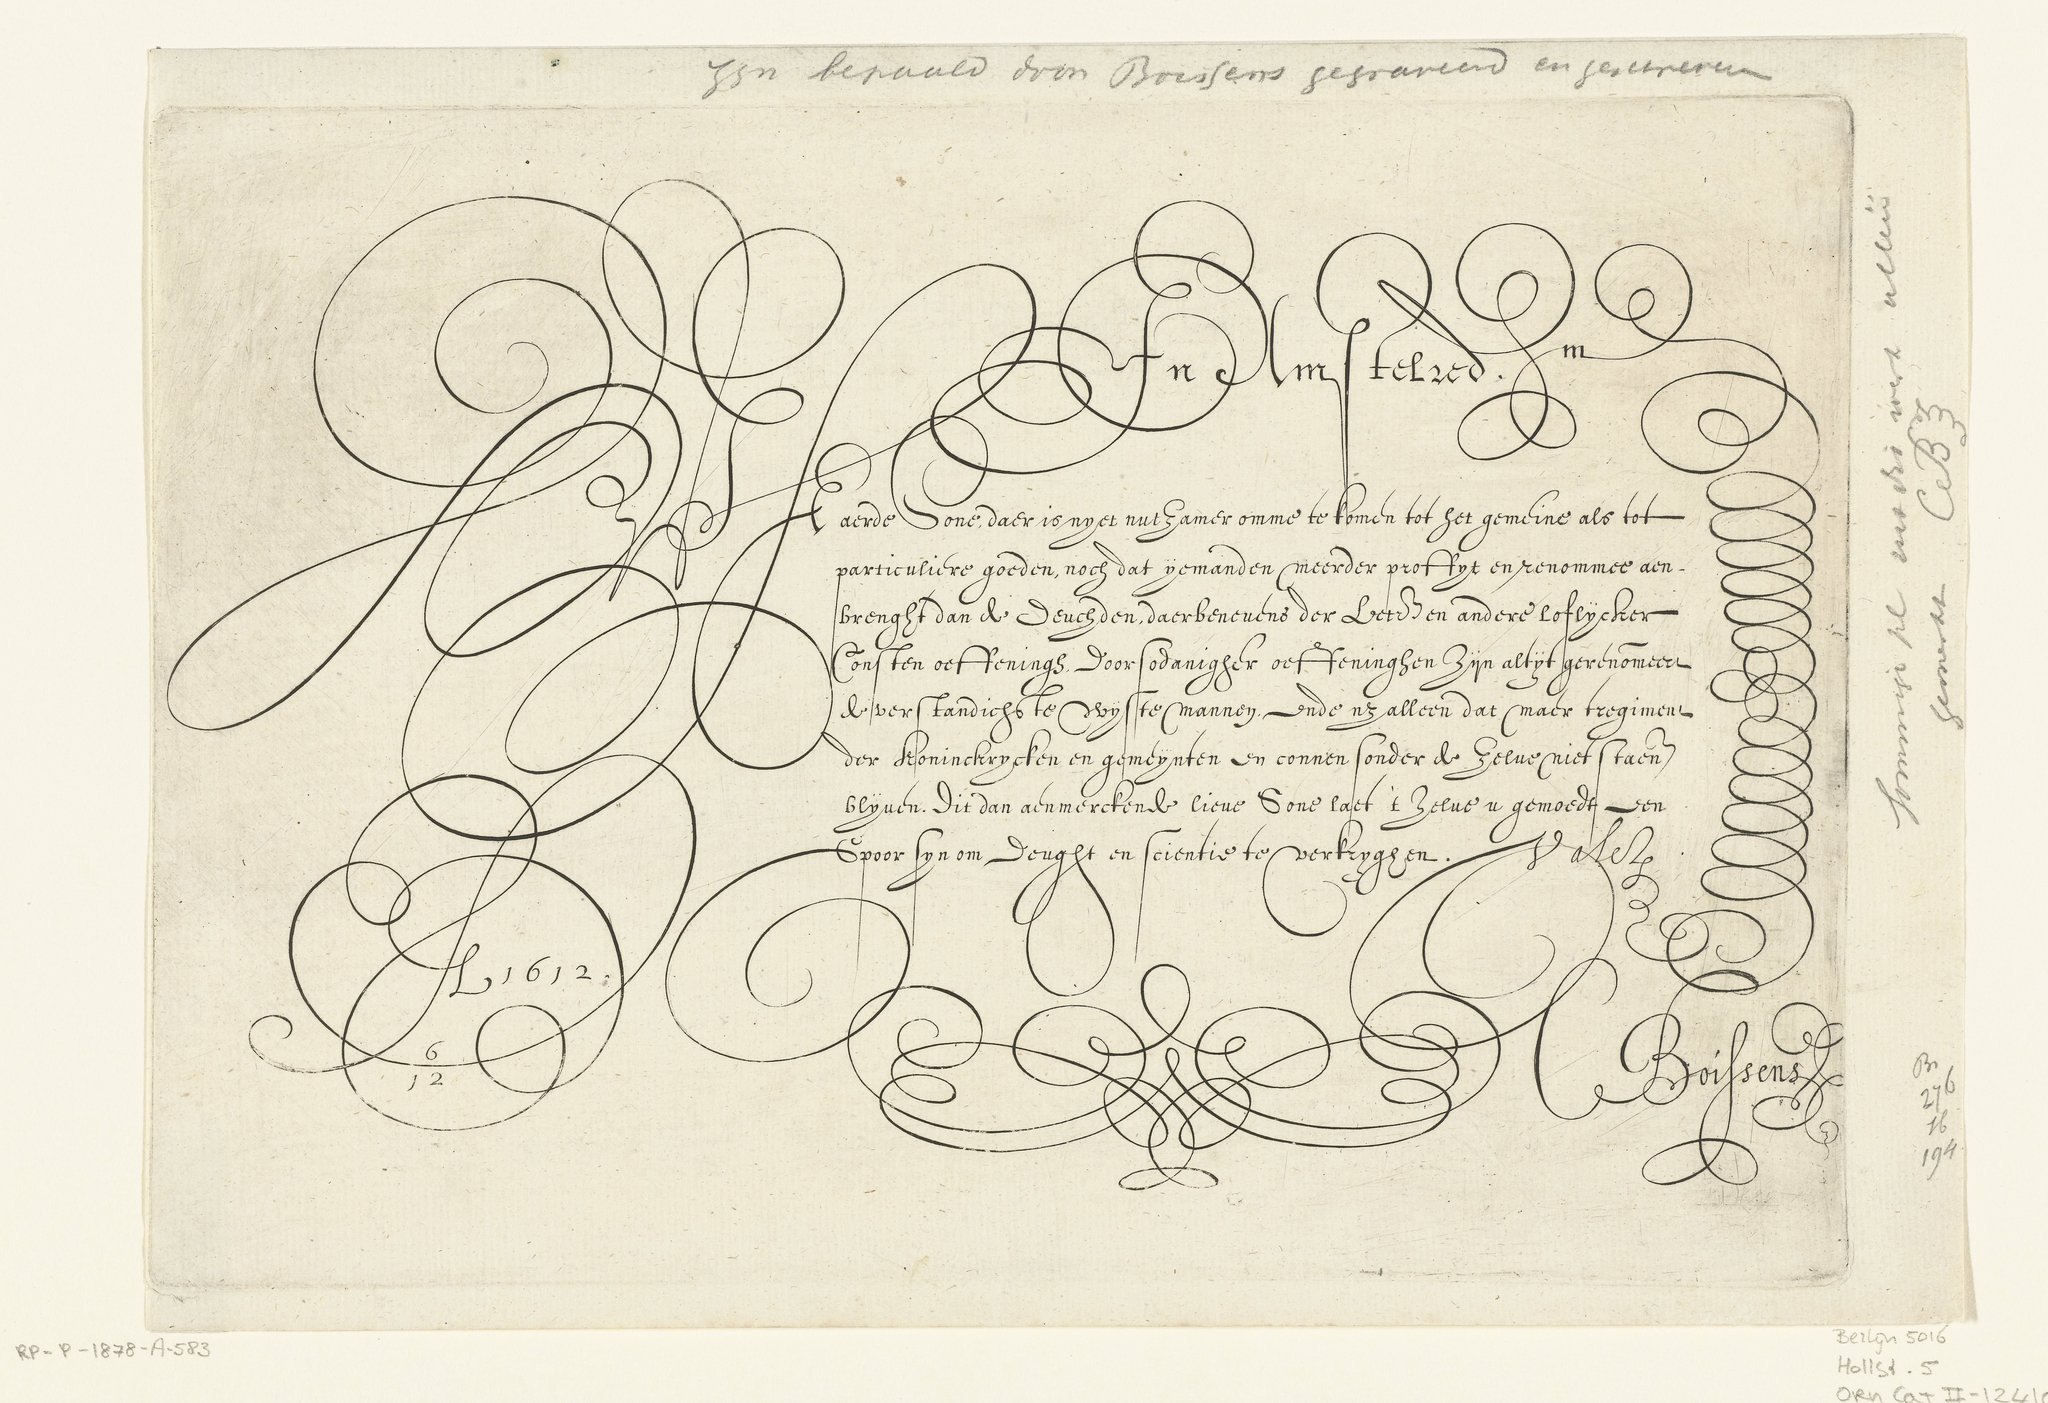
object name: print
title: Kalligrafie: ‘Waerde Sone daer is nuet nutzamer omme te komen tot het gemeine als tot particuliere goeden….’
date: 1612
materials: paper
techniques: engraving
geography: amsterdam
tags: calligraphy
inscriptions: date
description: De tekst staat midden boven in een frame van kalligrafische versiering. Uit serie van 34 bladen.